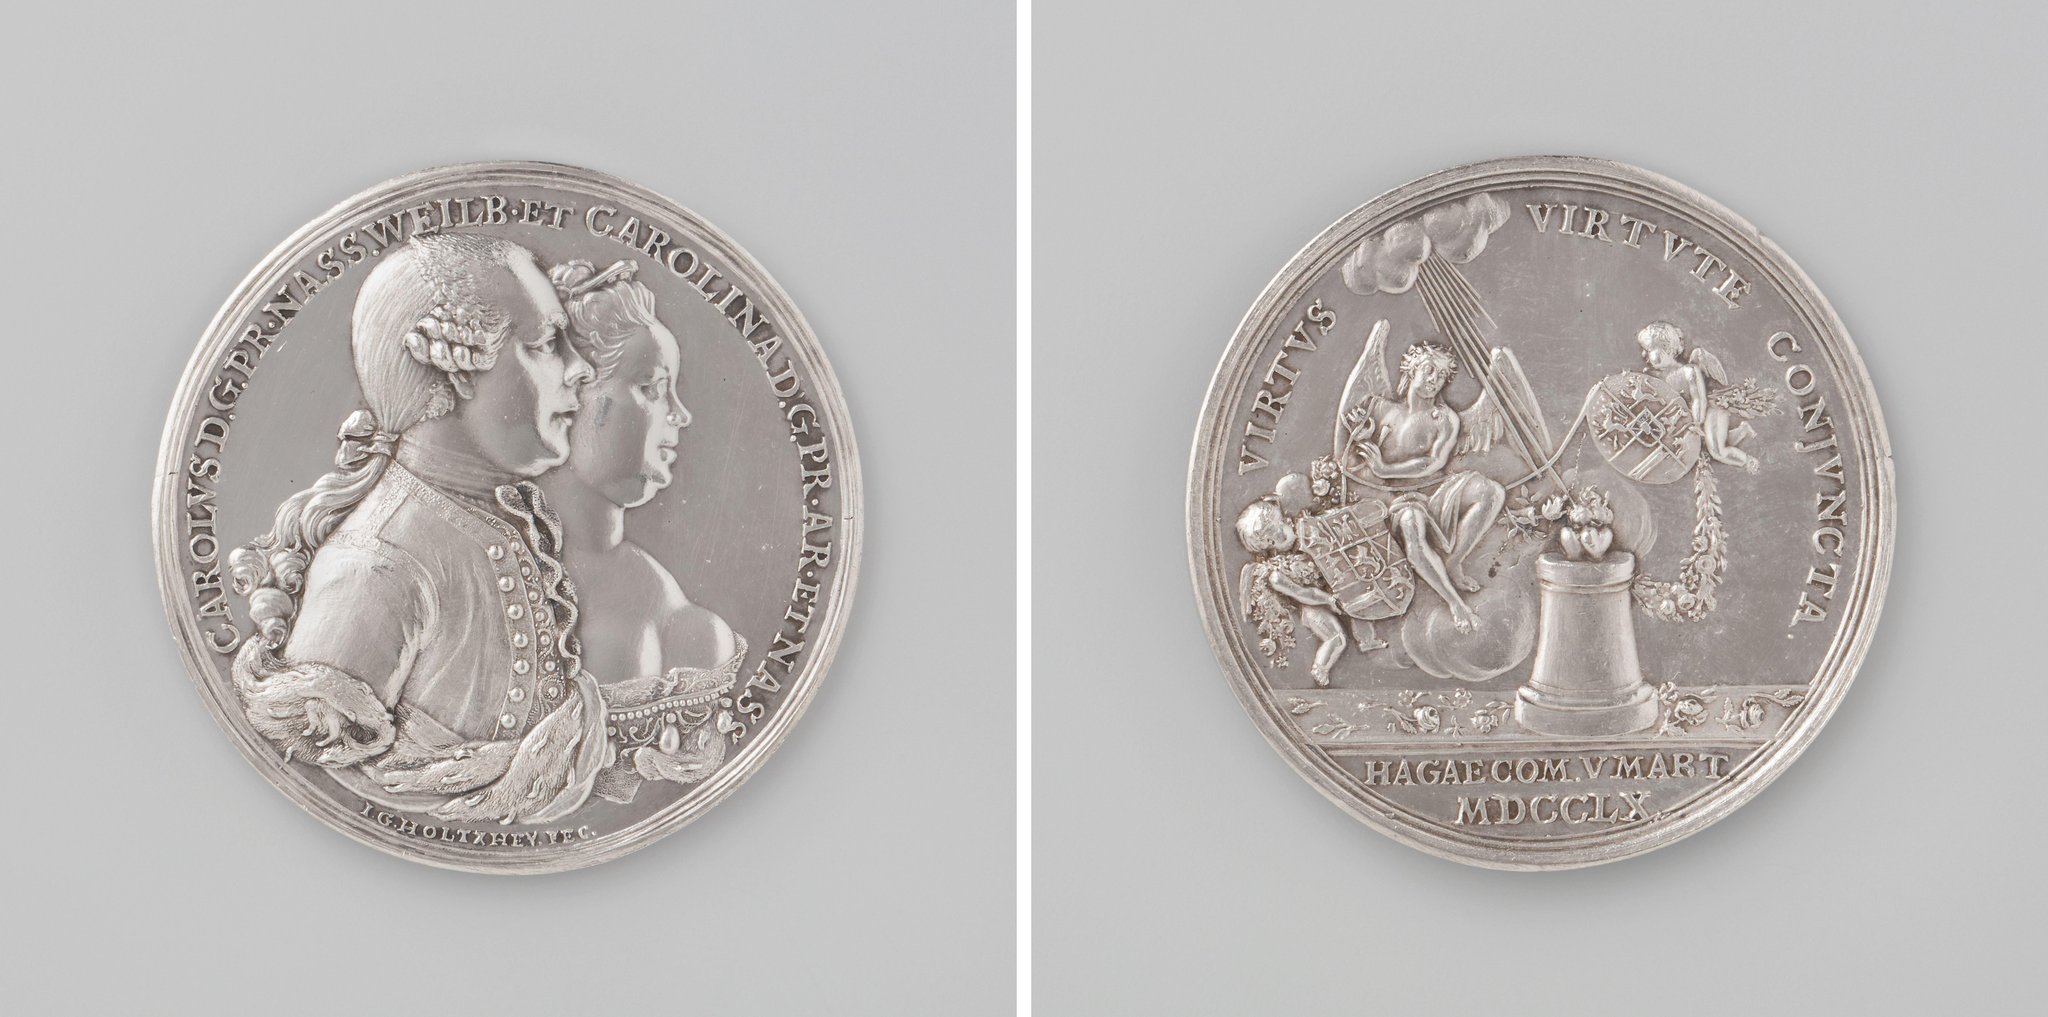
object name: history medal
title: Huwelijk van Karel Christiaan van Nassau-Weilburg en Carolina, prinses van Oranje-Nassau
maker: johan george holtzhey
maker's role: mintmaster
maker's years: 1726-1808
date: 1760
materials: silver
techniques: striking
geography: amsterdam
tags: carolina (prinses van oranje-nassau), karel christiaan vorst van nassau-weilburg, the hague